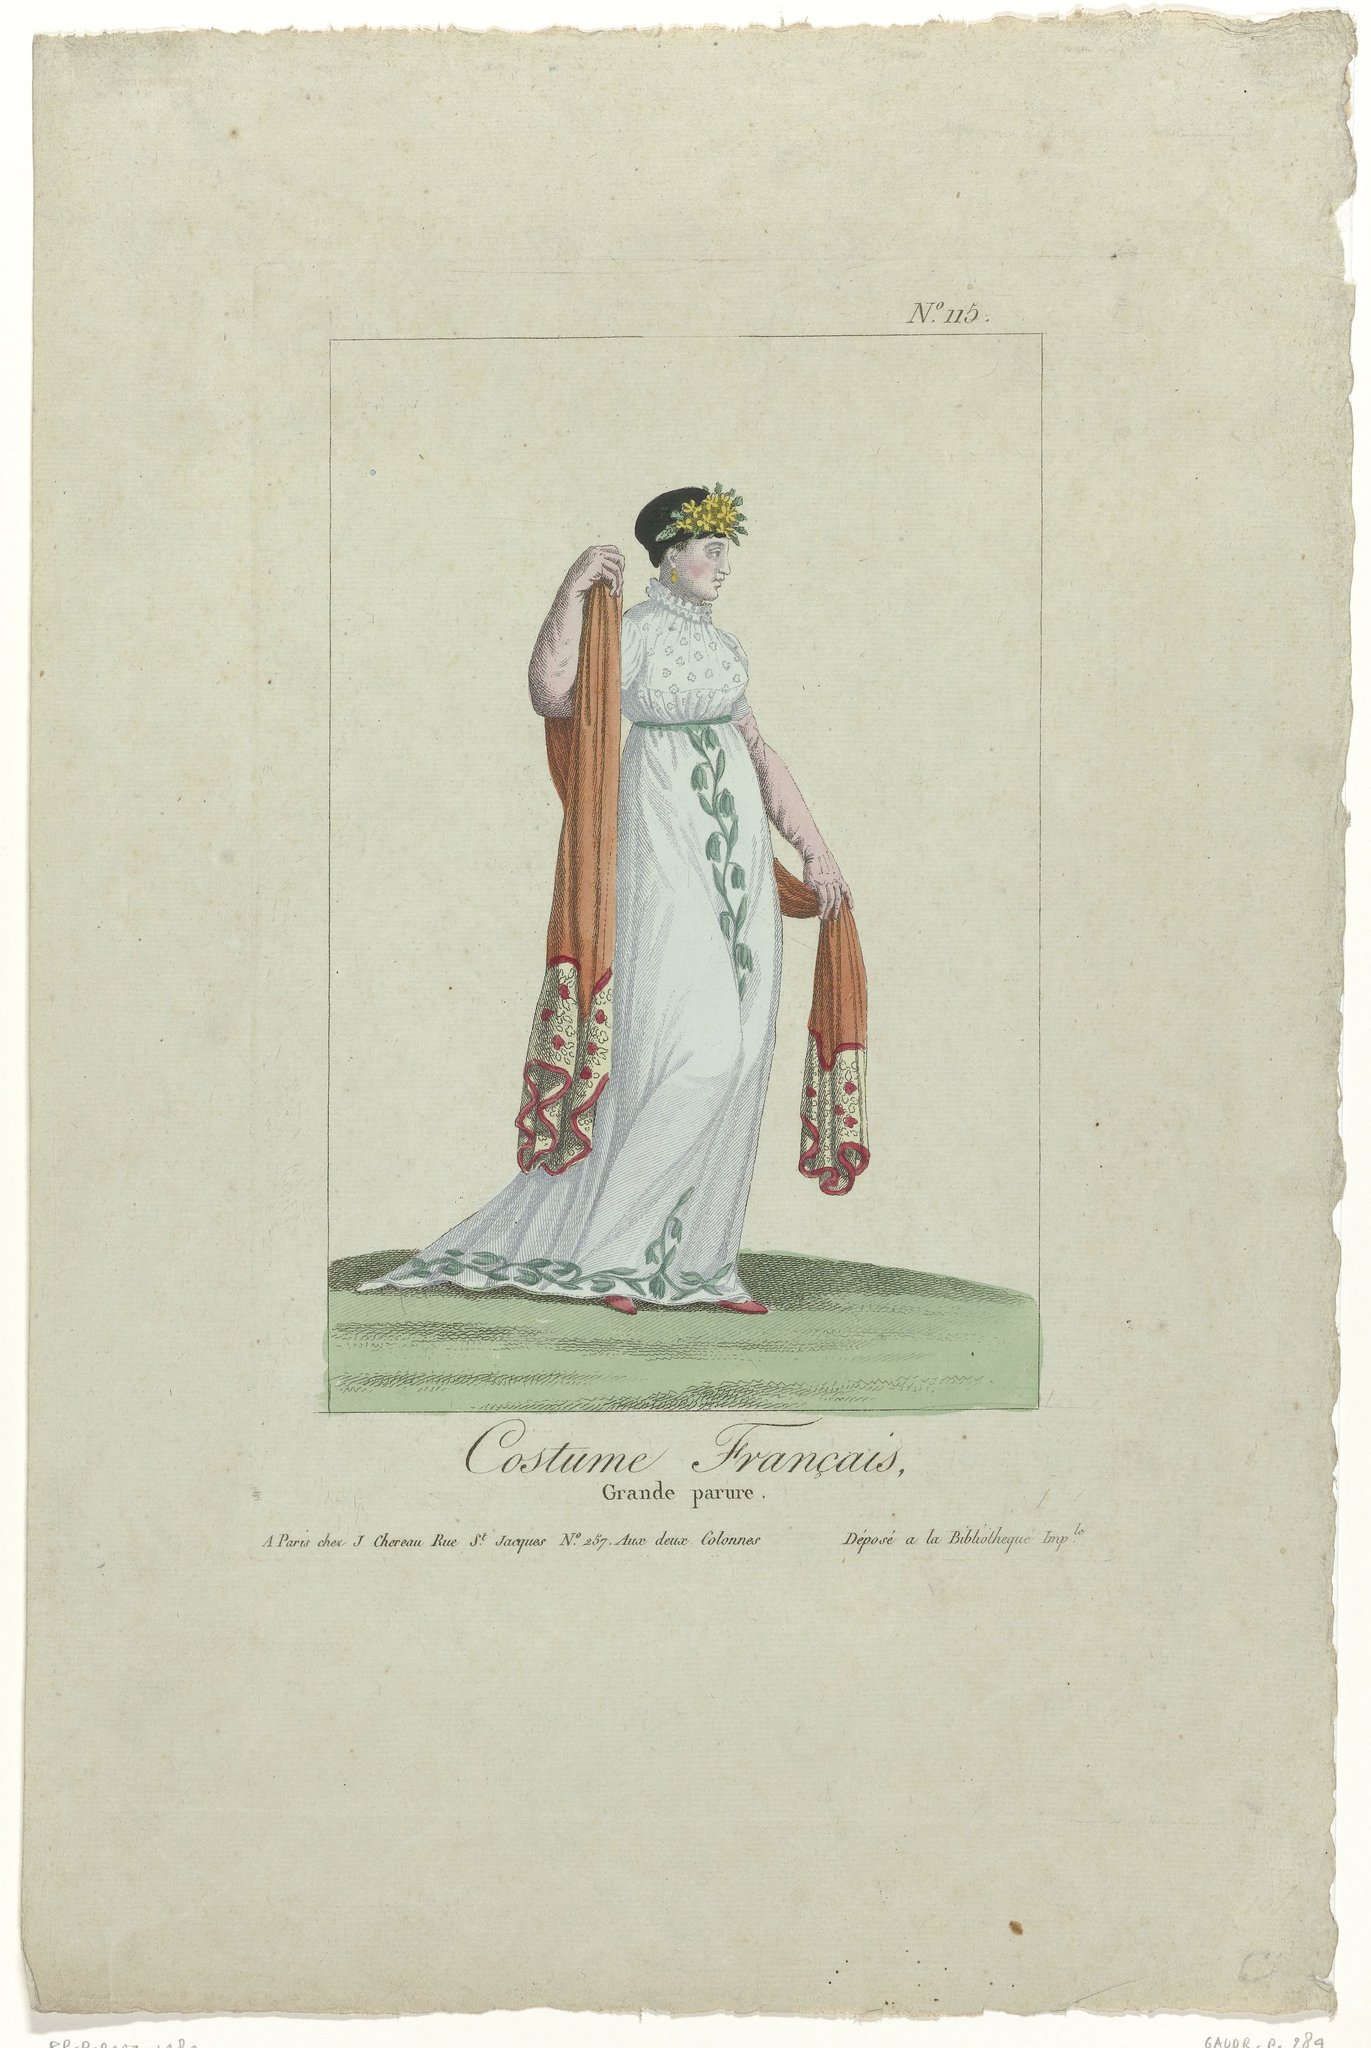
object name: fashion print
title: Costume Français, puis Nouveau Costume Parisien 1799-1810, No. 115: Grande parure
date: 1799-1810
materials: paper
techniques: engraving, etching, hand coloring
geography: paris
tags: ear-rings (+ women's clothes), gloves, mittens (long gloves) (+ women's clothes), clothing for the upper part of the body (shawl) (+ women's clothes), head-gear (+ women's clothes), fashion plates, shoes, sandals (+ women's clothes), dress, gown (+ women's clothes)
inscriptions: caption: ‘Déposé à la Bibliothèque Imp.le’, caption: ‘Costume Français / Grande parure’, address: ‘A Paris, chez J. Chéreau. Rue St. Jacques No. 257. Aux deux Colonnes’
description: Vrouw, lopend naar rechts, in 'grand parure' : japon met sleep, middenvoor en bij de zoom versierd met guirlande. Accessoires: hoed met bloemen, oorbel in het rechteroor, lange handschoenen, sjaal versierd met bloemmotief, schoenen. De prent maakt deel uit van een serie van 142 modeprenten, waarvan er 115 zijn geïdentificeerd, uitgegeven door J. Chéreau, Parijs, 1799-1810.